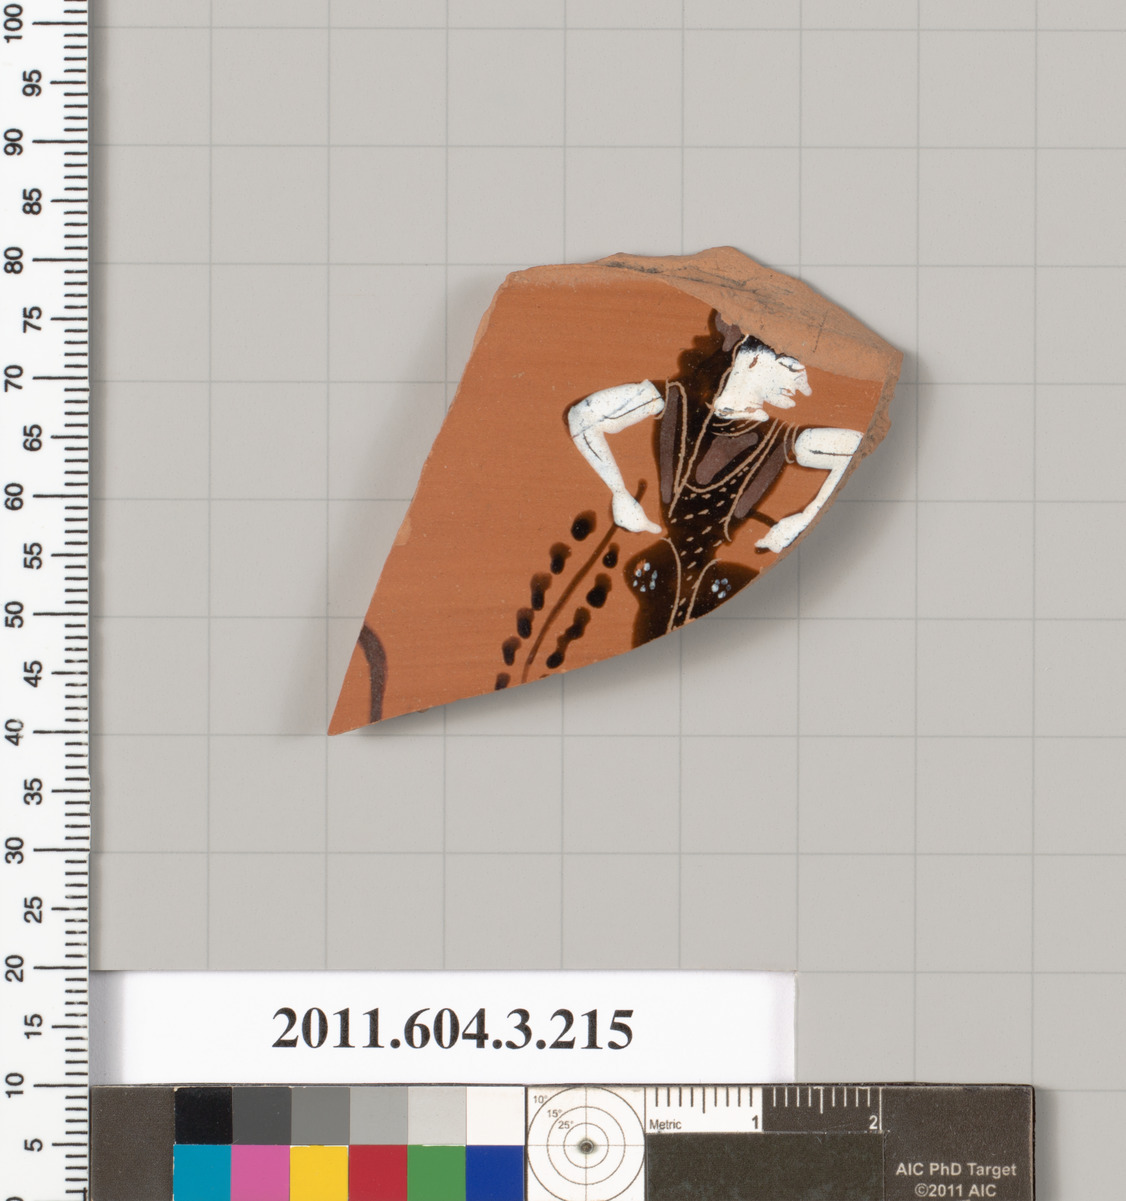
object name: neck amphora fragment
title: Terracotta fragment of a neck-amphora of Nicosthenic shape (jar)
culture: greek, attic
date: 525-501 BCE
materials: terracotta